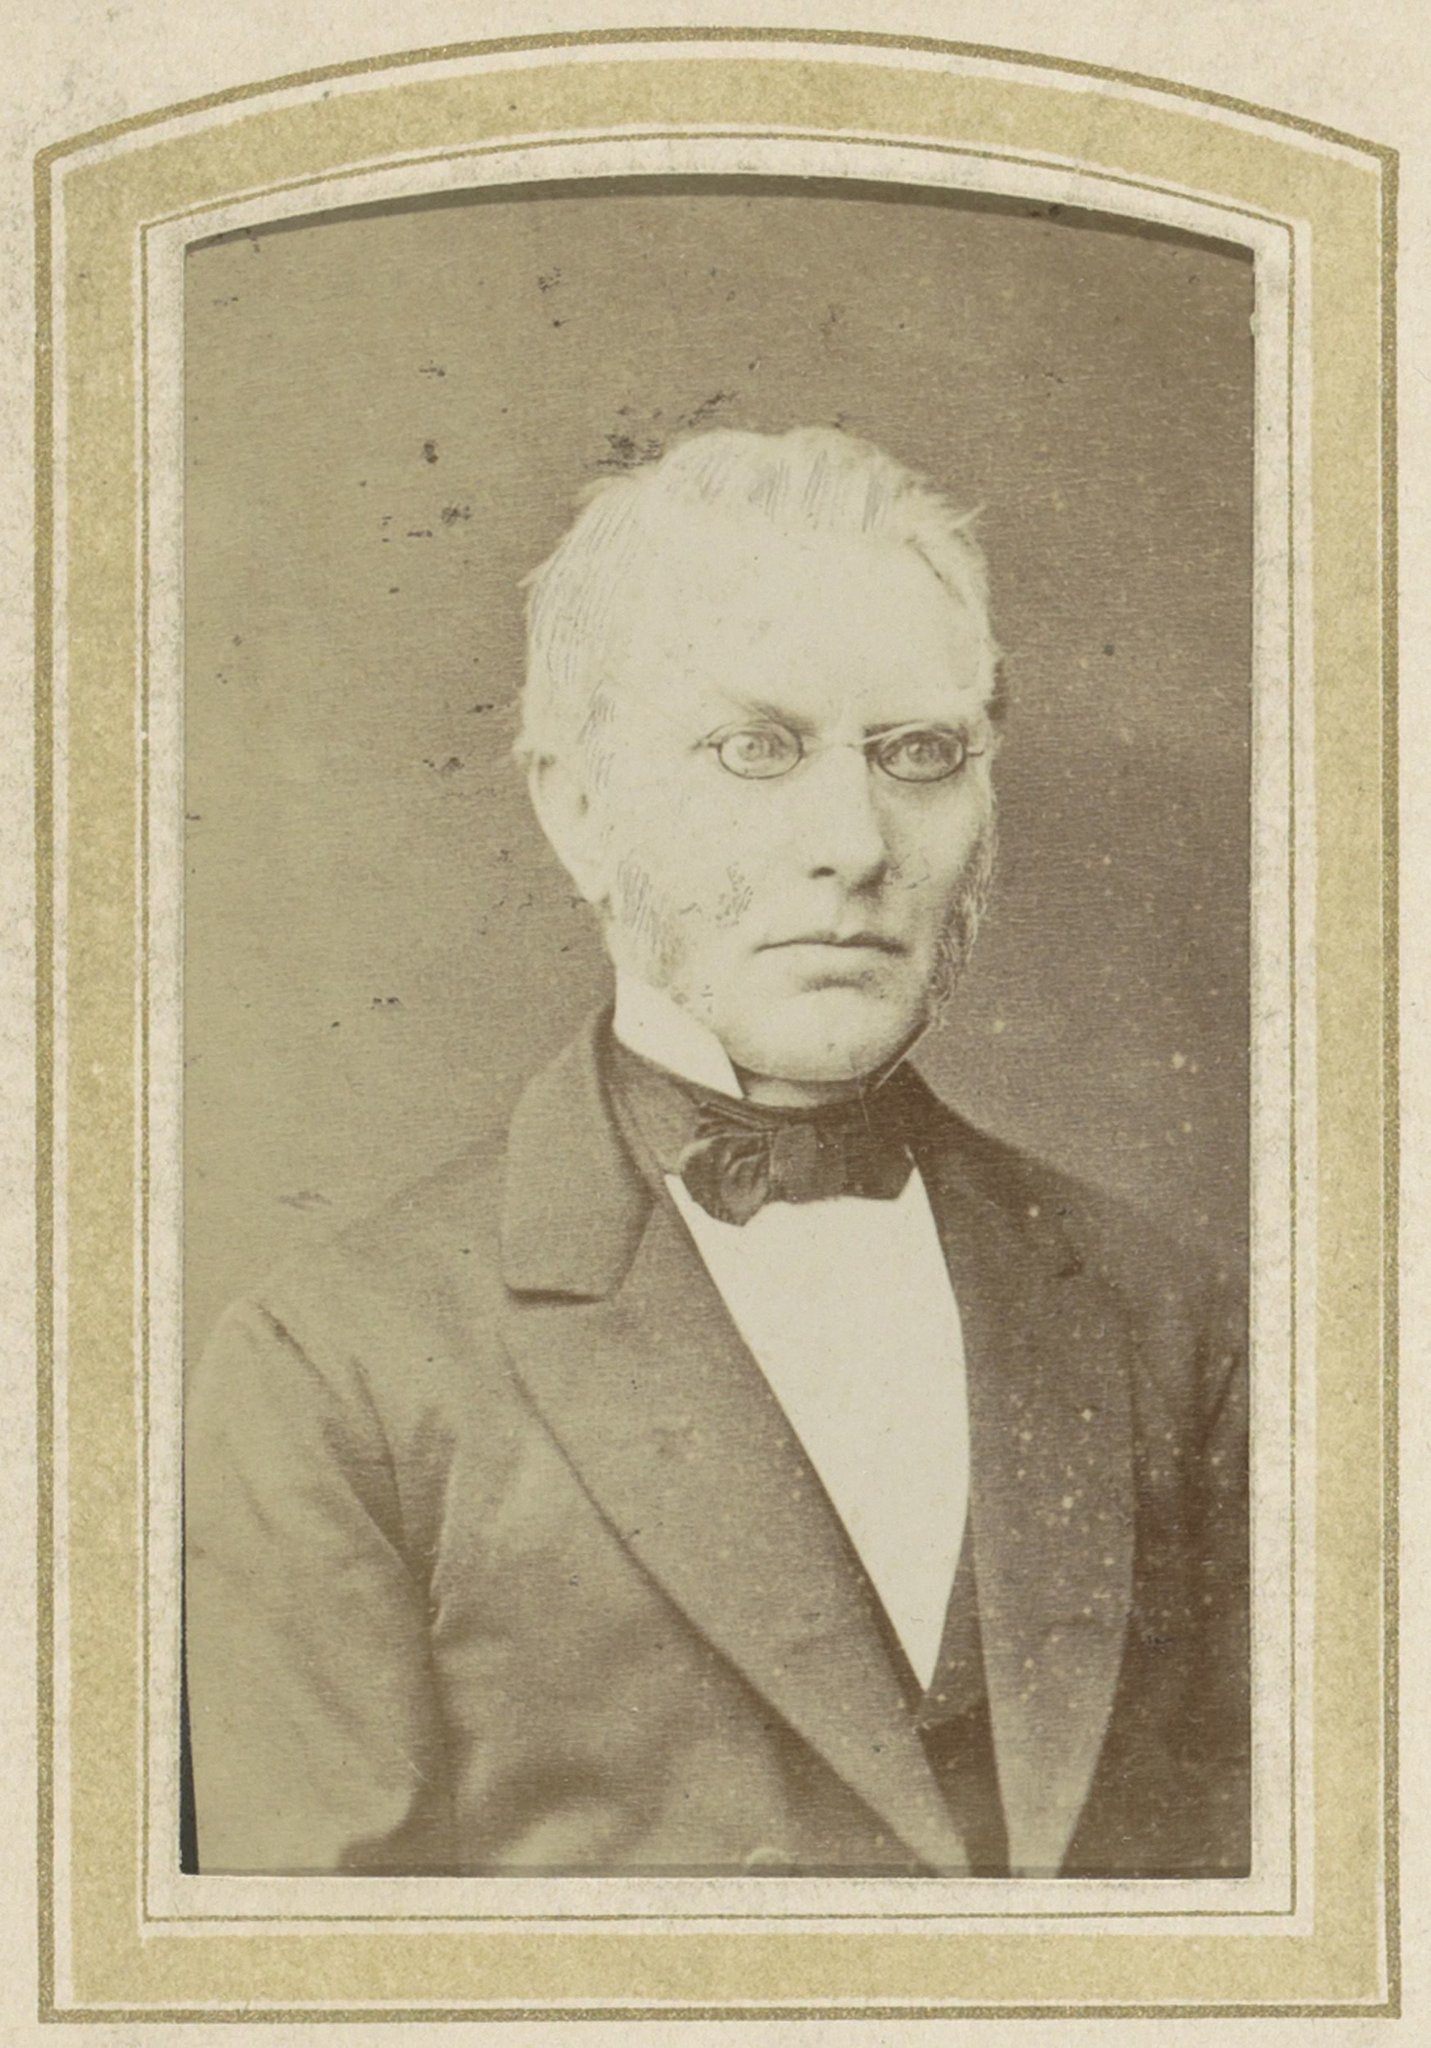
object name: carte de visite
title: Portret van een man met een bril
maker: Anonymous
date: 1860-1900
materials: cardboard, paper, photographic support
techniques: albumen print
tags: eyeglasses, spectacles, historical persons, neck-gear ~ clothing, clothing for the upper part of the body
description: Onderdeel van Fotoalbum van een Nederlandse familie met 168 cartes-de-visite en kabinetfoto's.